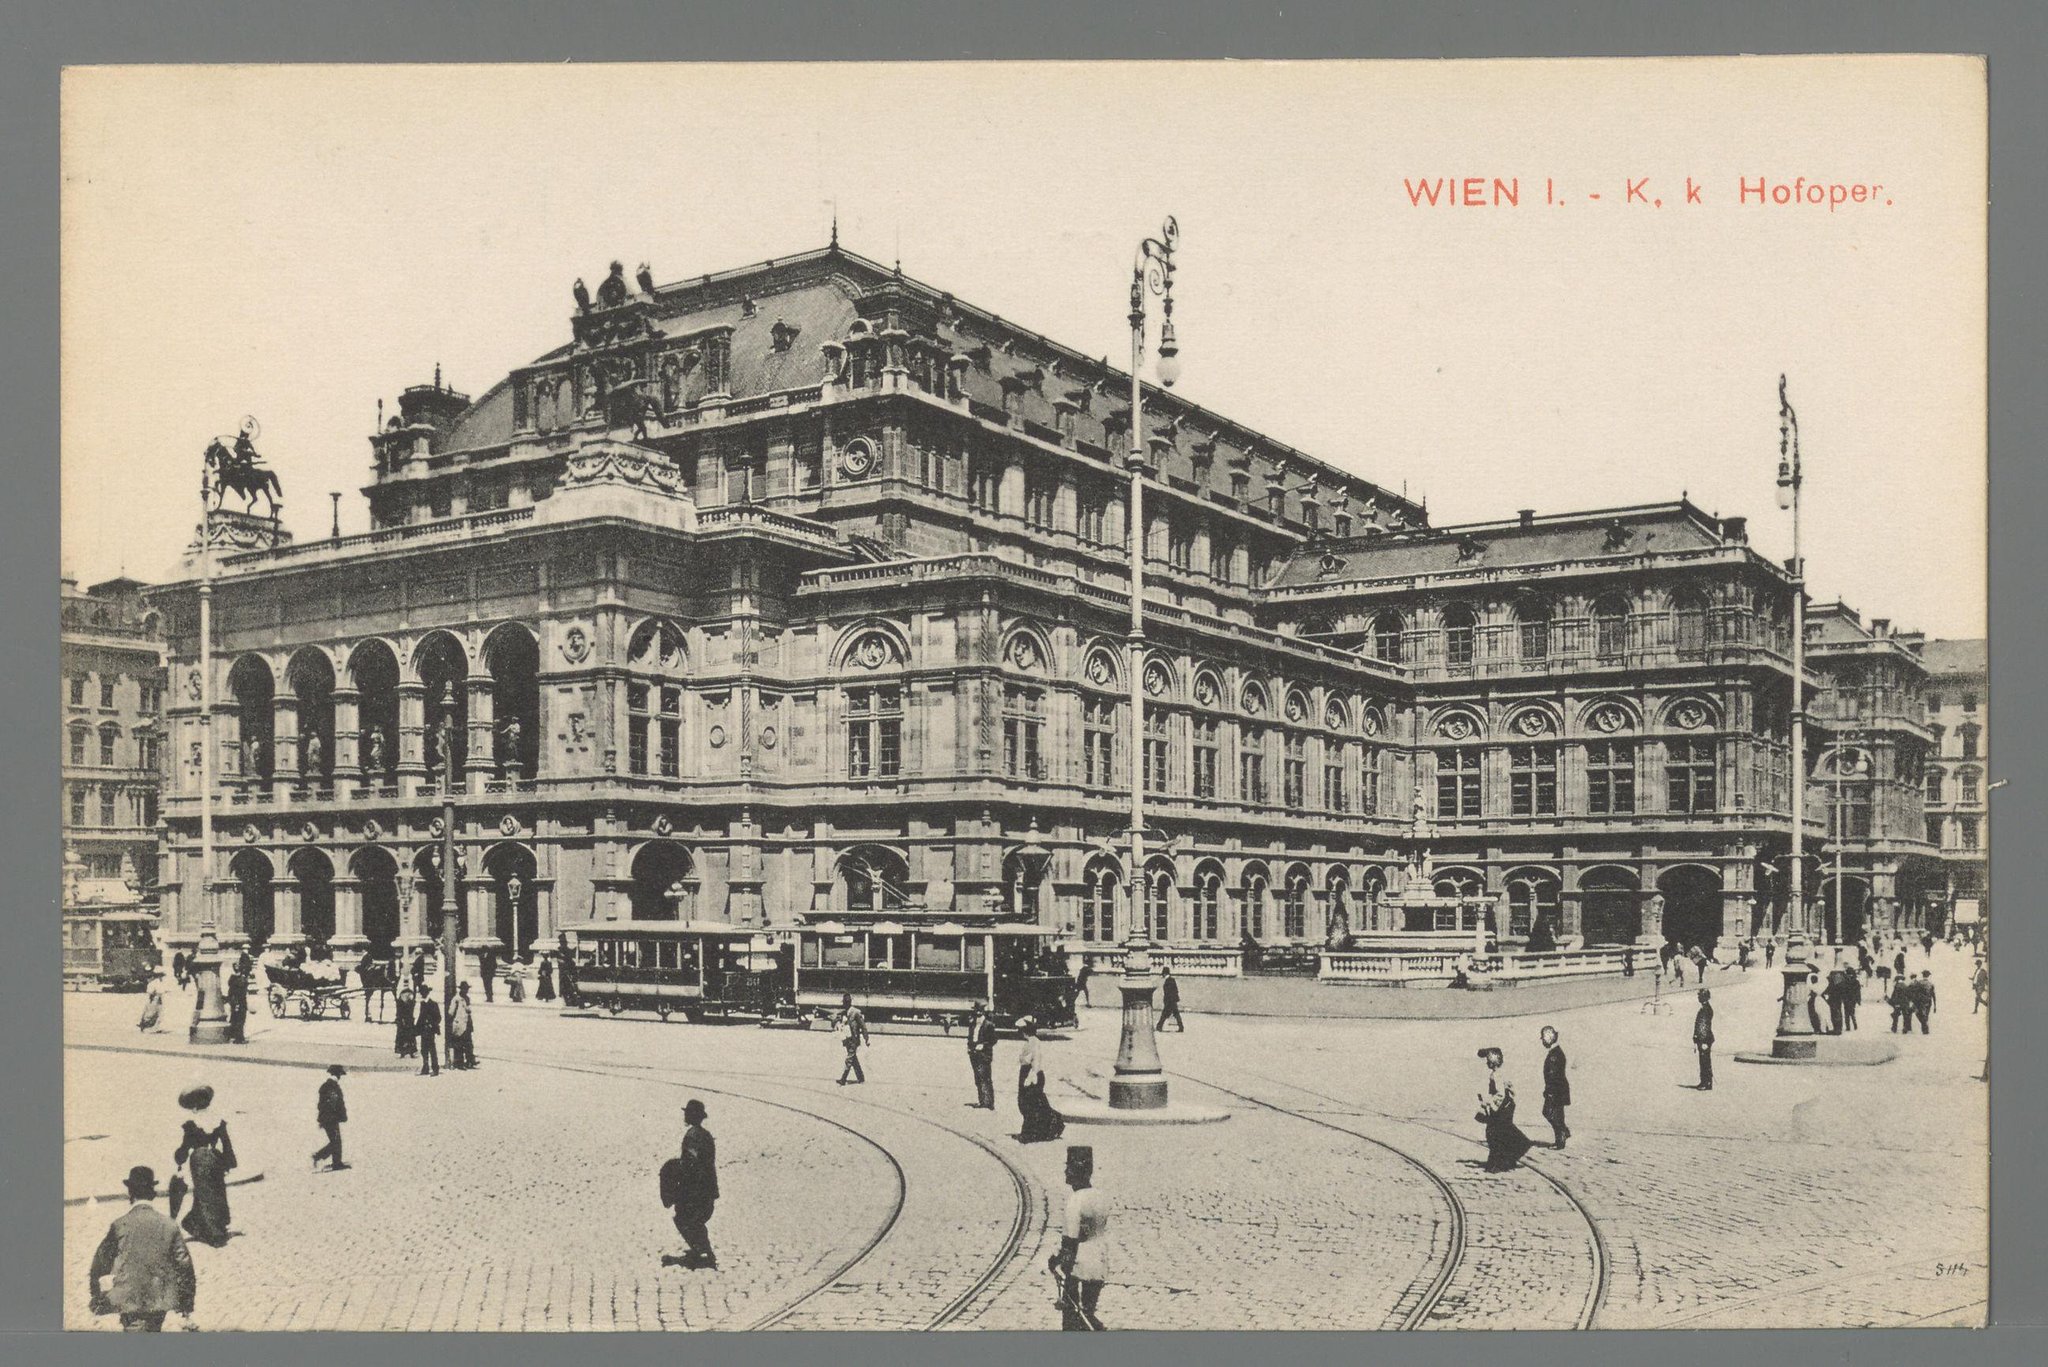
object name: ansichtkaart, prentbriefkaart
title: Wien I. - K. k Hofoper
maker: Anonymous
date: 1904-1930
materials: cardboard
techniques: photograph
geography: vienna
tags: opera house